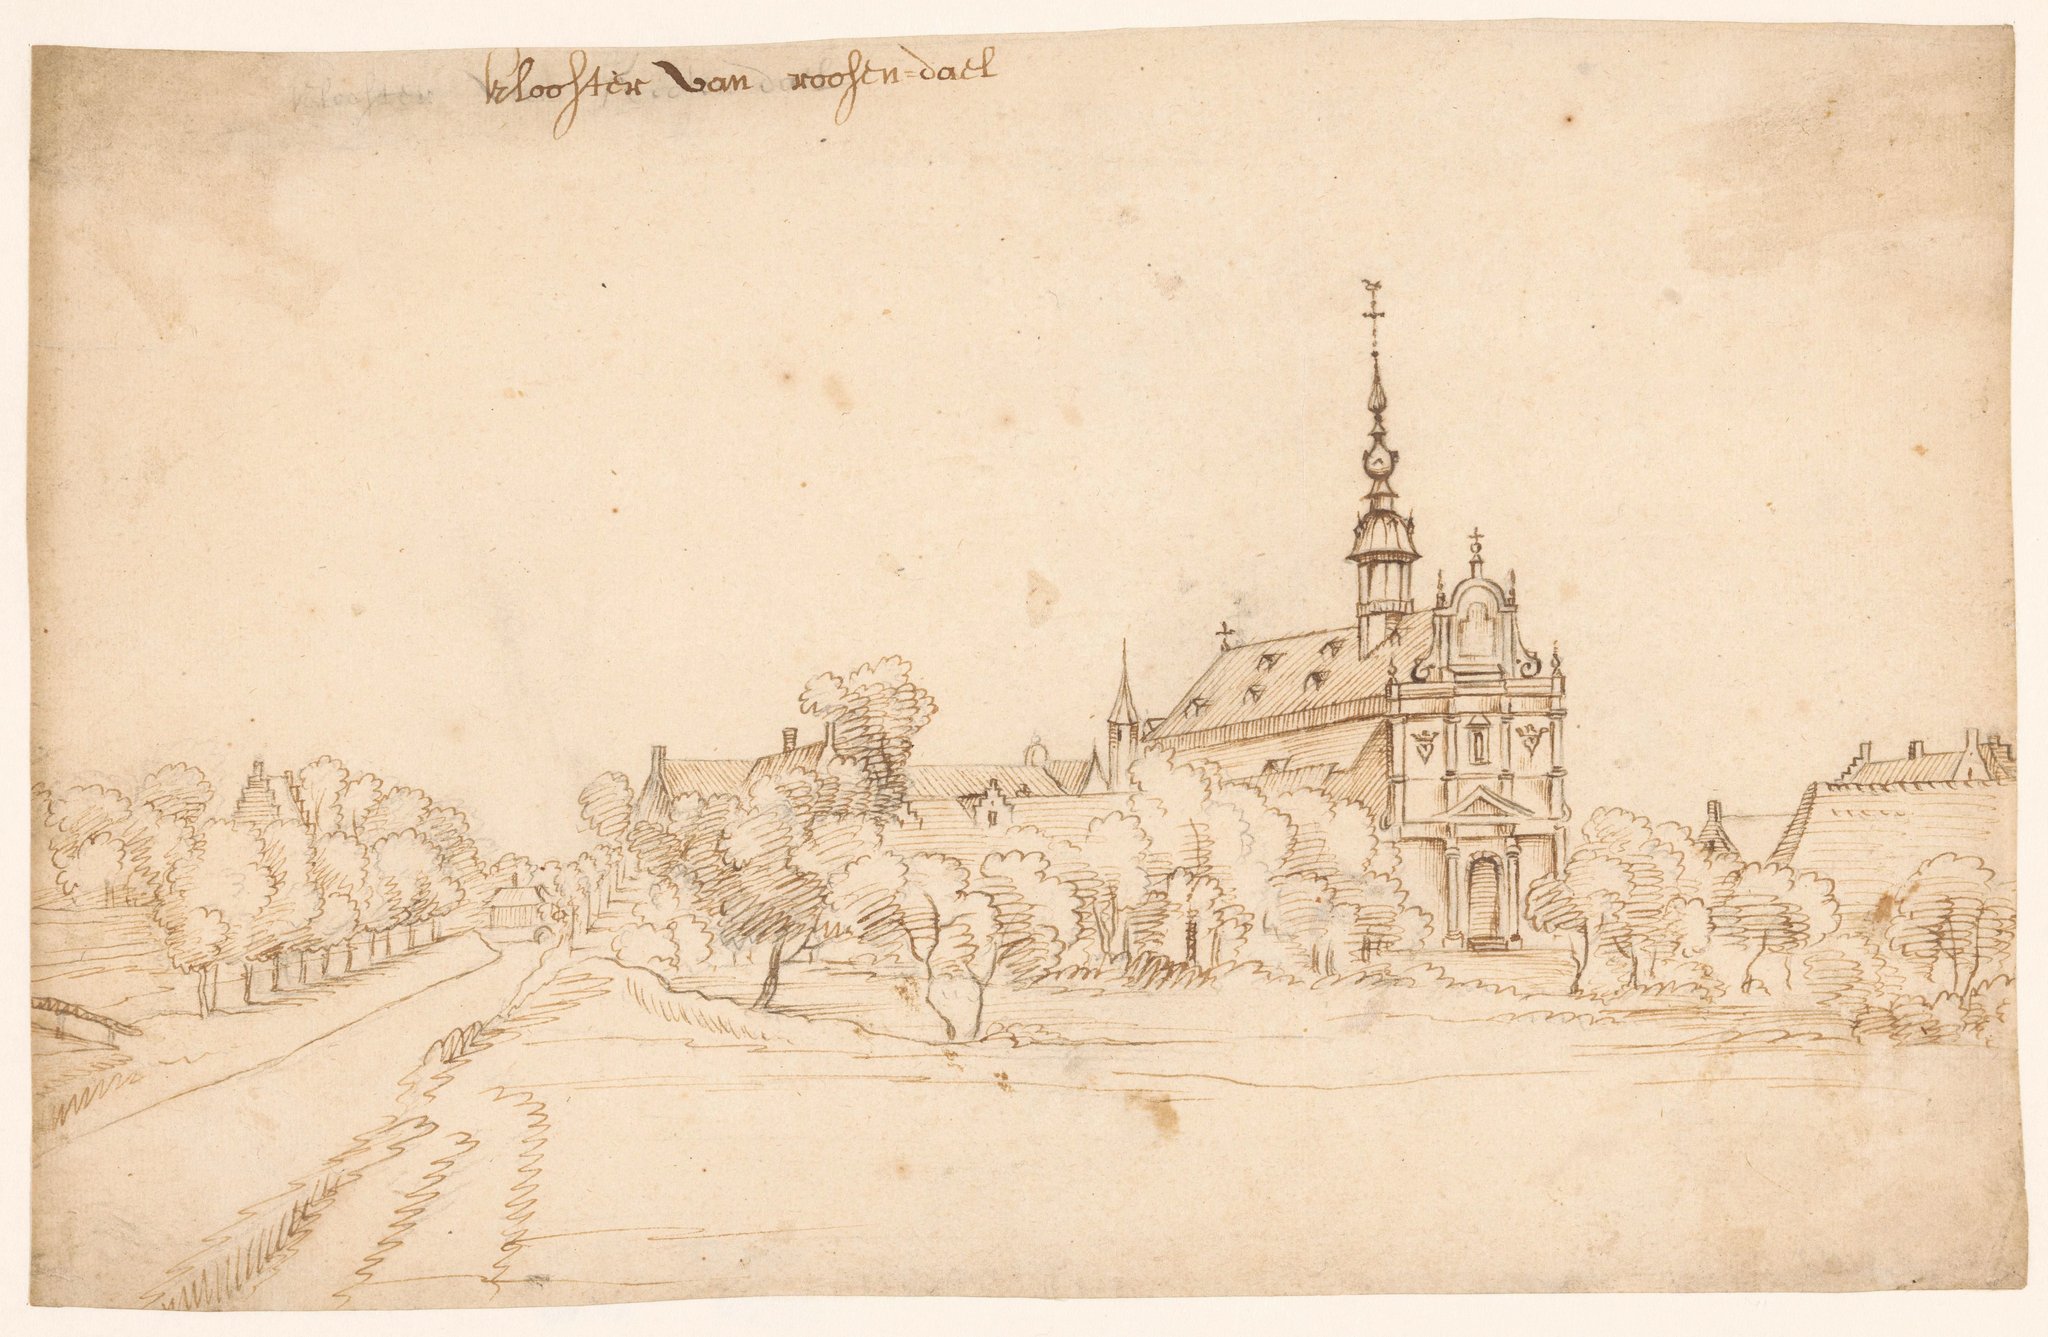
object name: drawing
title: Het klooster Roosendael in Walem, tussen geboomte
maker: h. van wel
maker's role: draughtsman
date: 1600-1699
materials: ink, paper, pencil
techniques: pen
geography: walem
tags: abbey, monastery, convent ~ roman catholic church